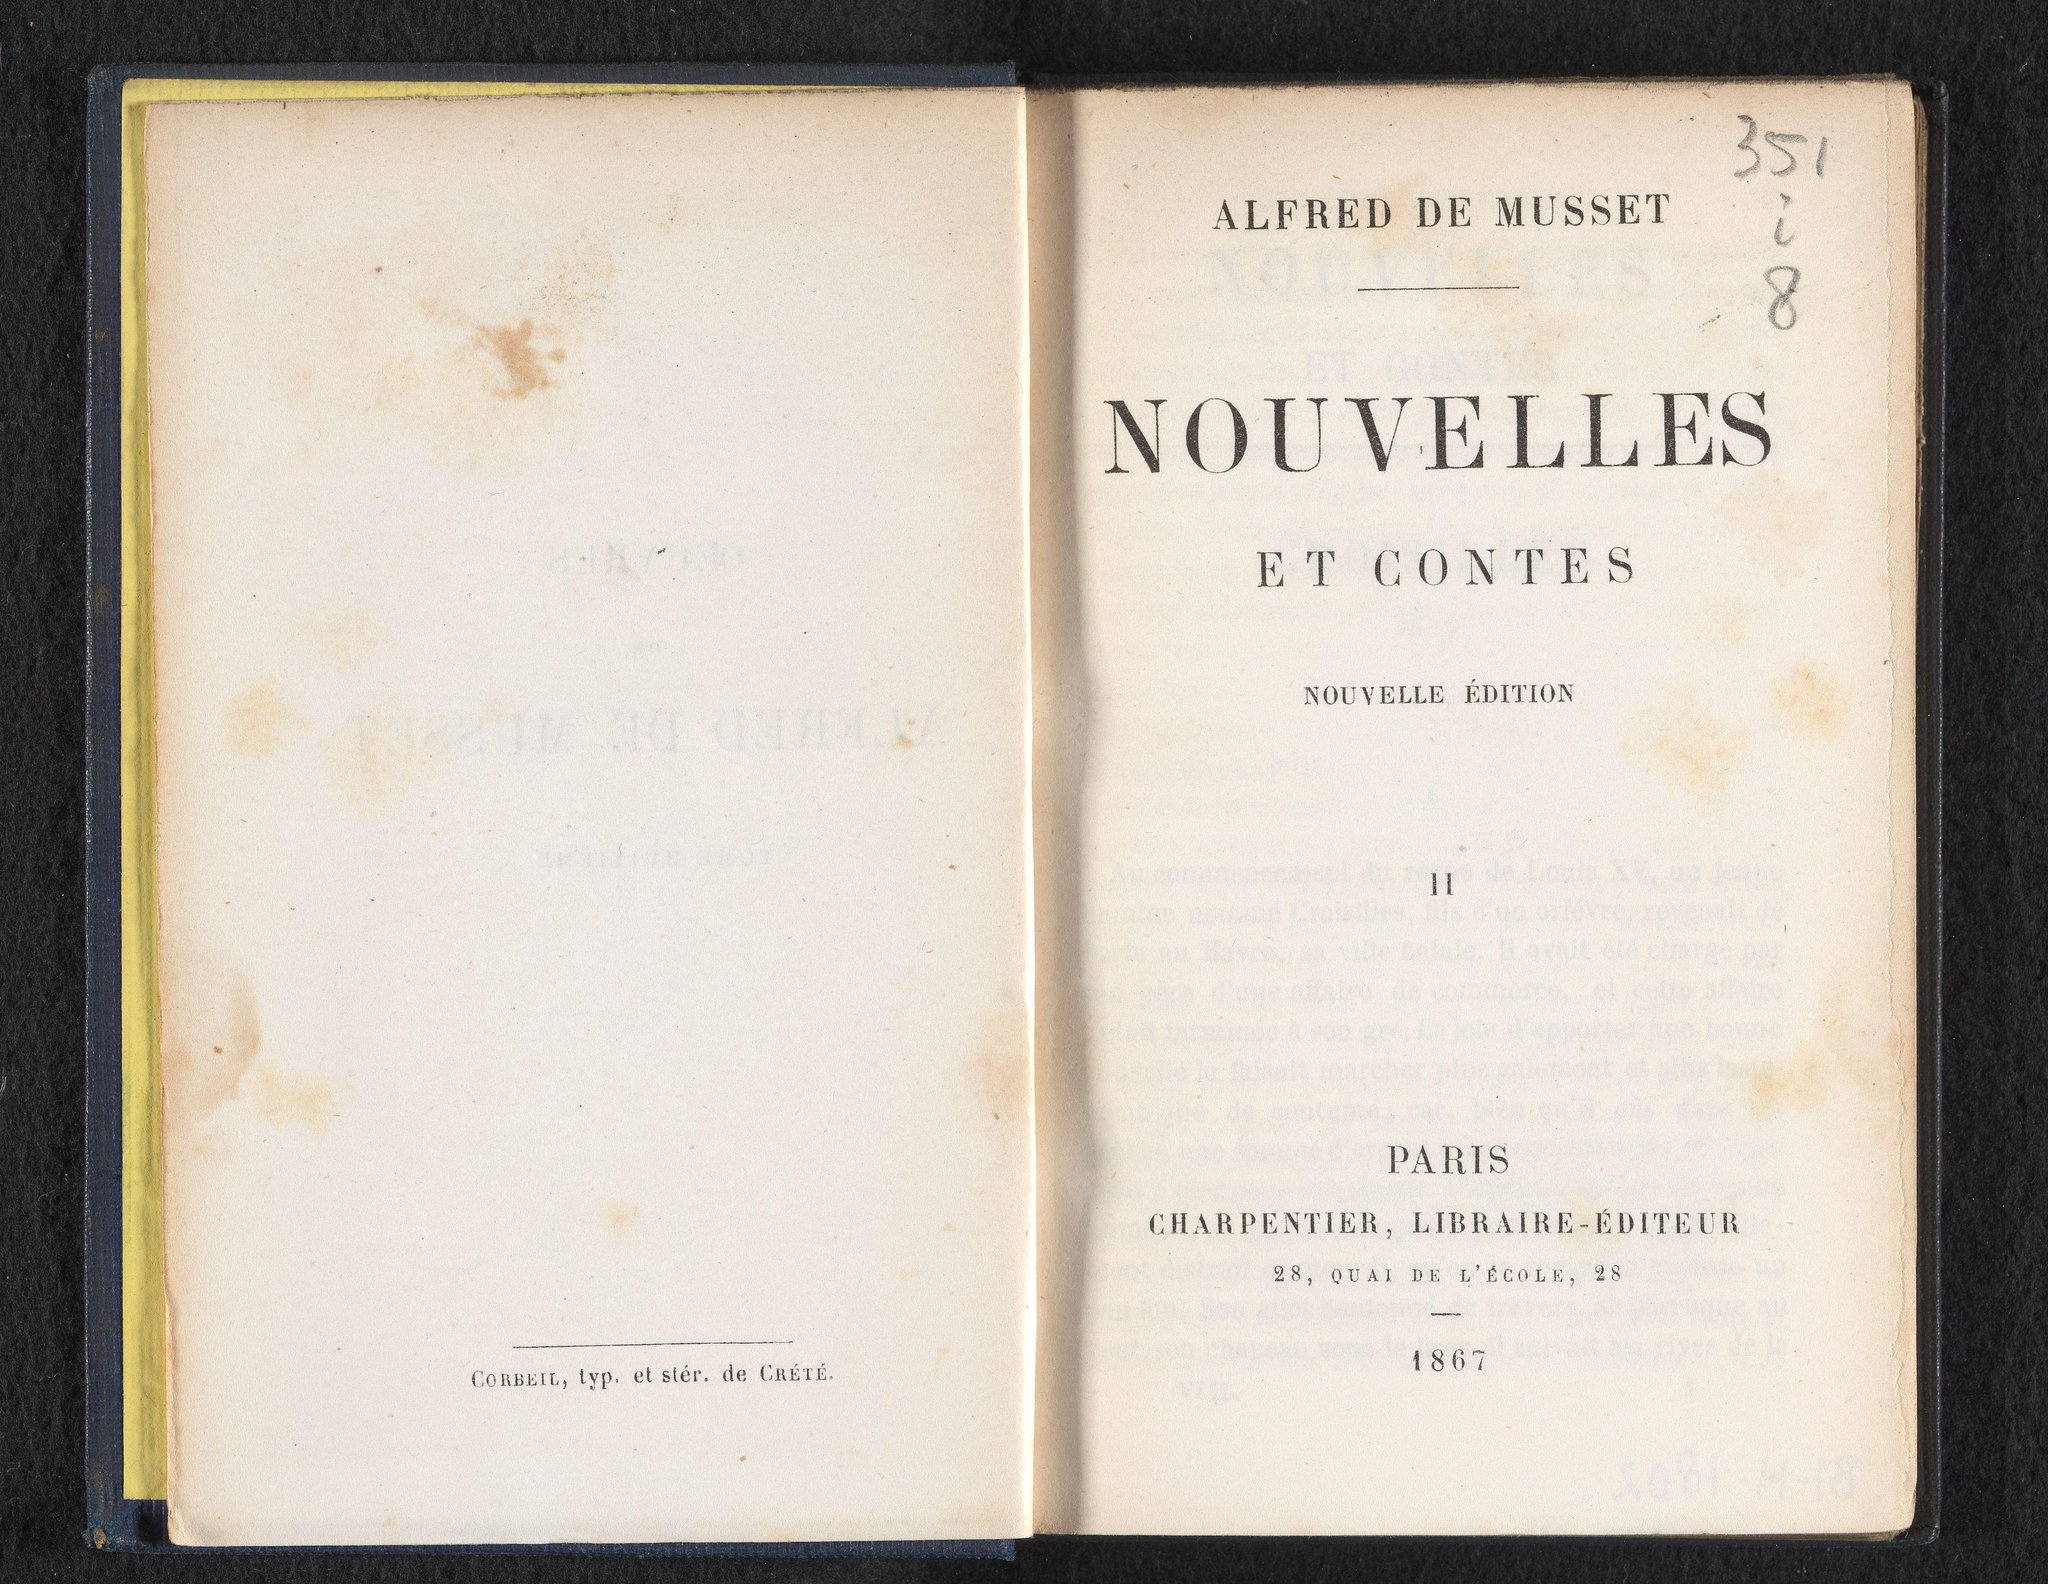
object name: book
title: Nouvelles et contes 2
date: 1867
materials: cardboard, paper, linen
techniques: albumen print, letterpress printing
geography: corbeil